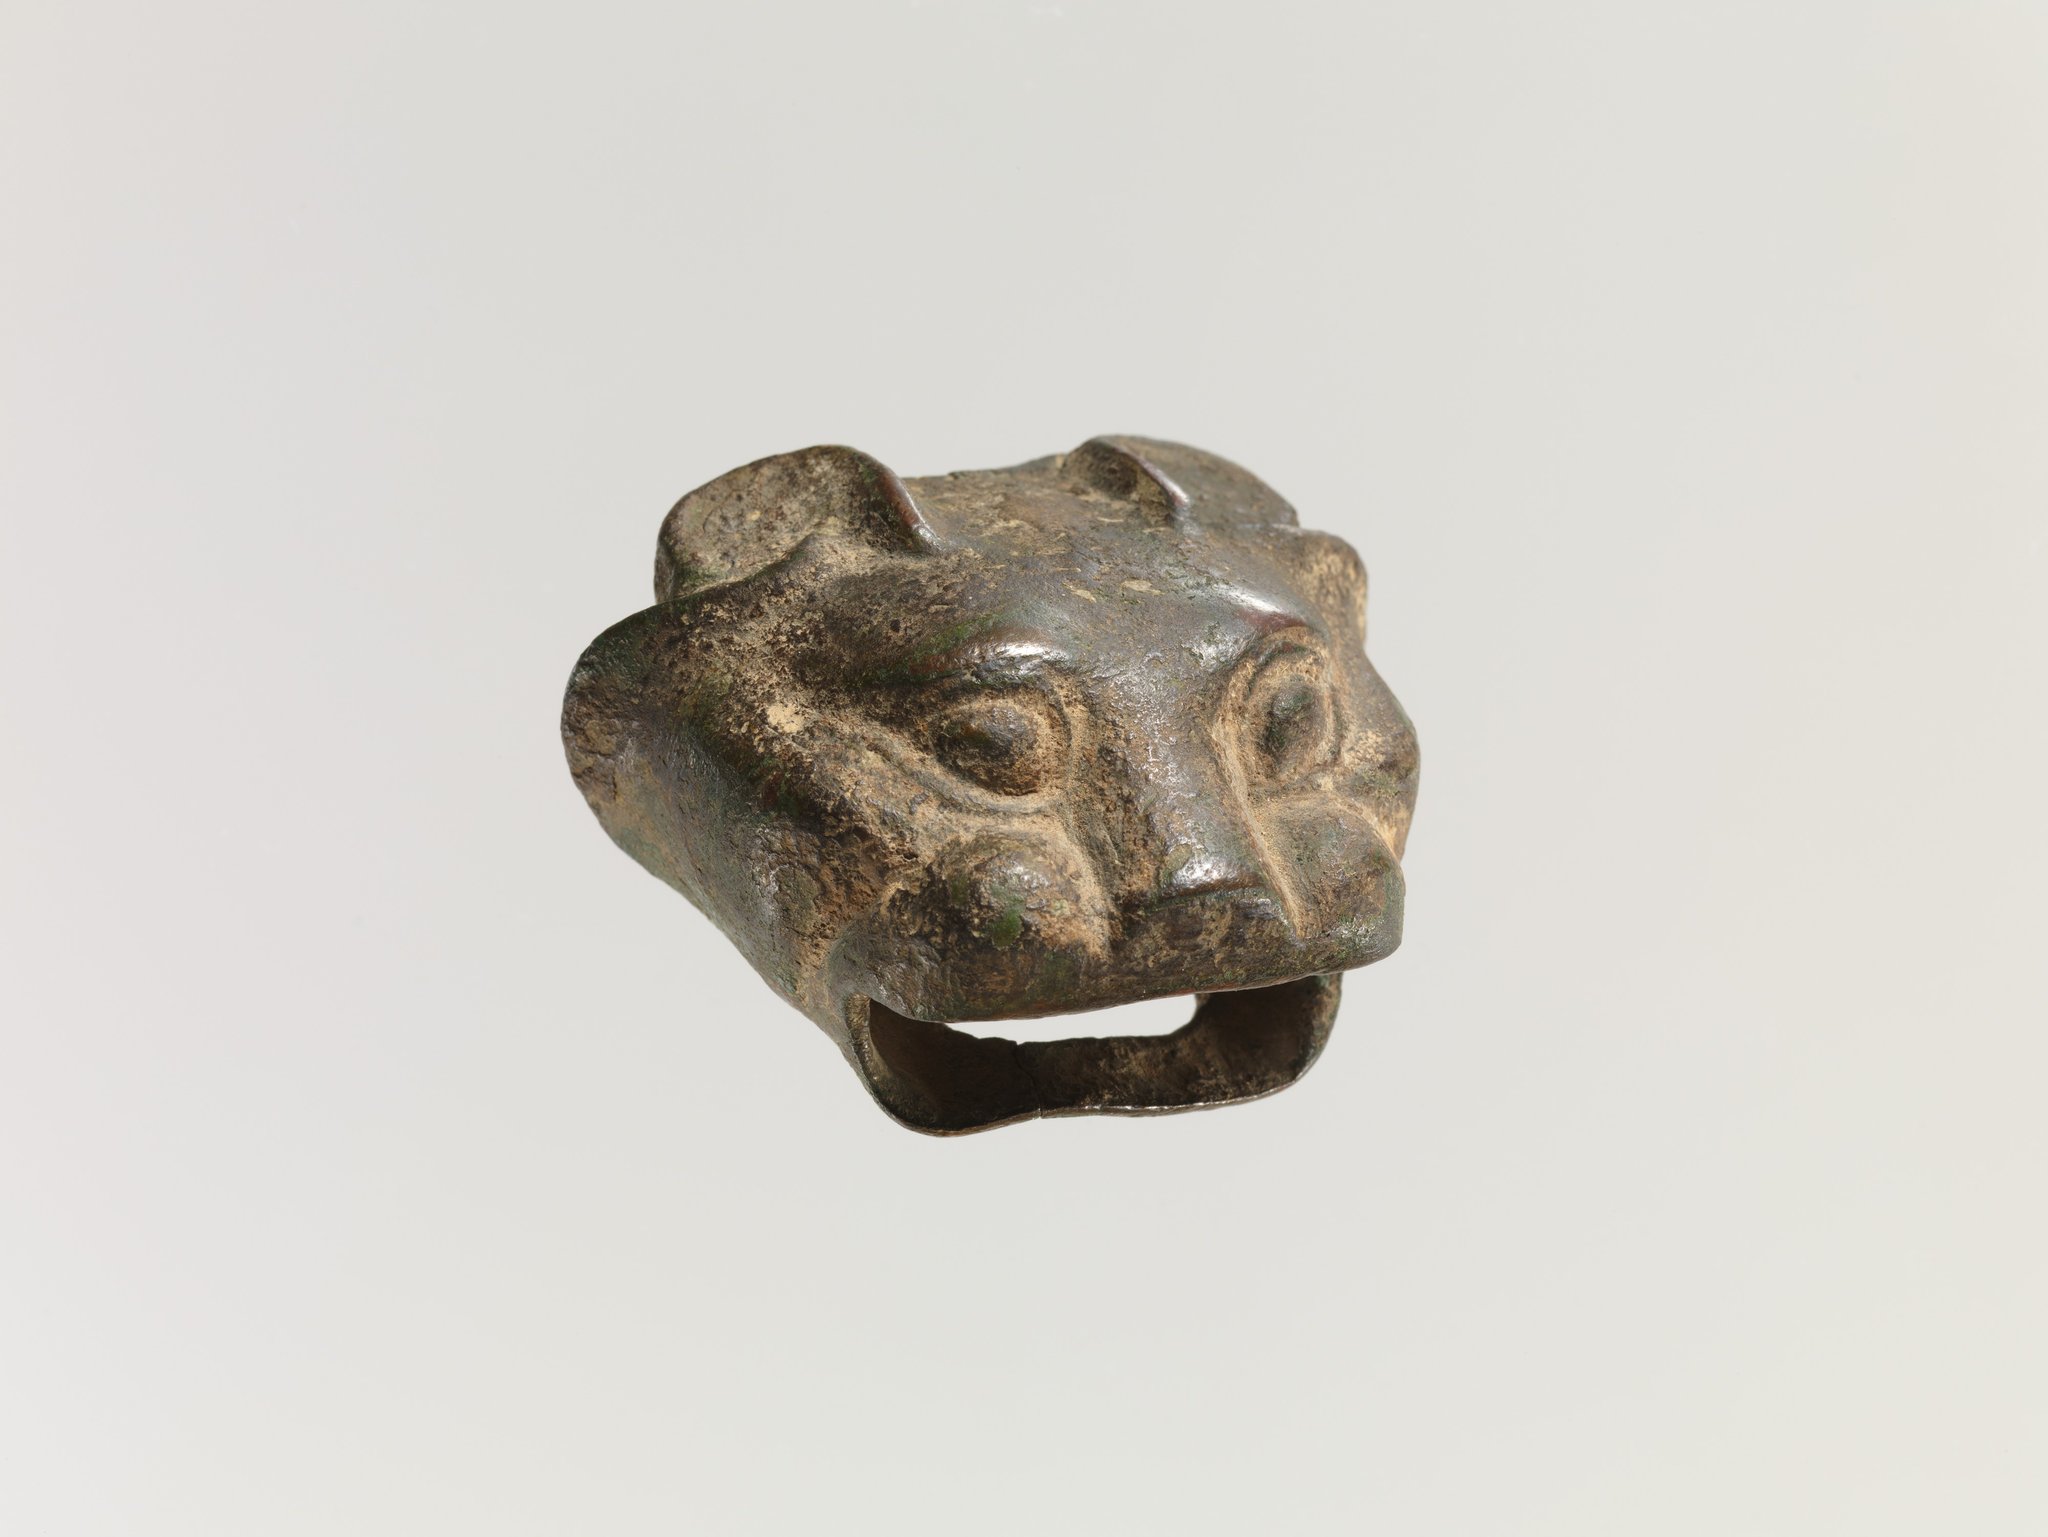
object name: mask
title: Mask of a Tiger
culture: chinese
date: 206 BCE-220 CE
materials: bronze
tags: masks